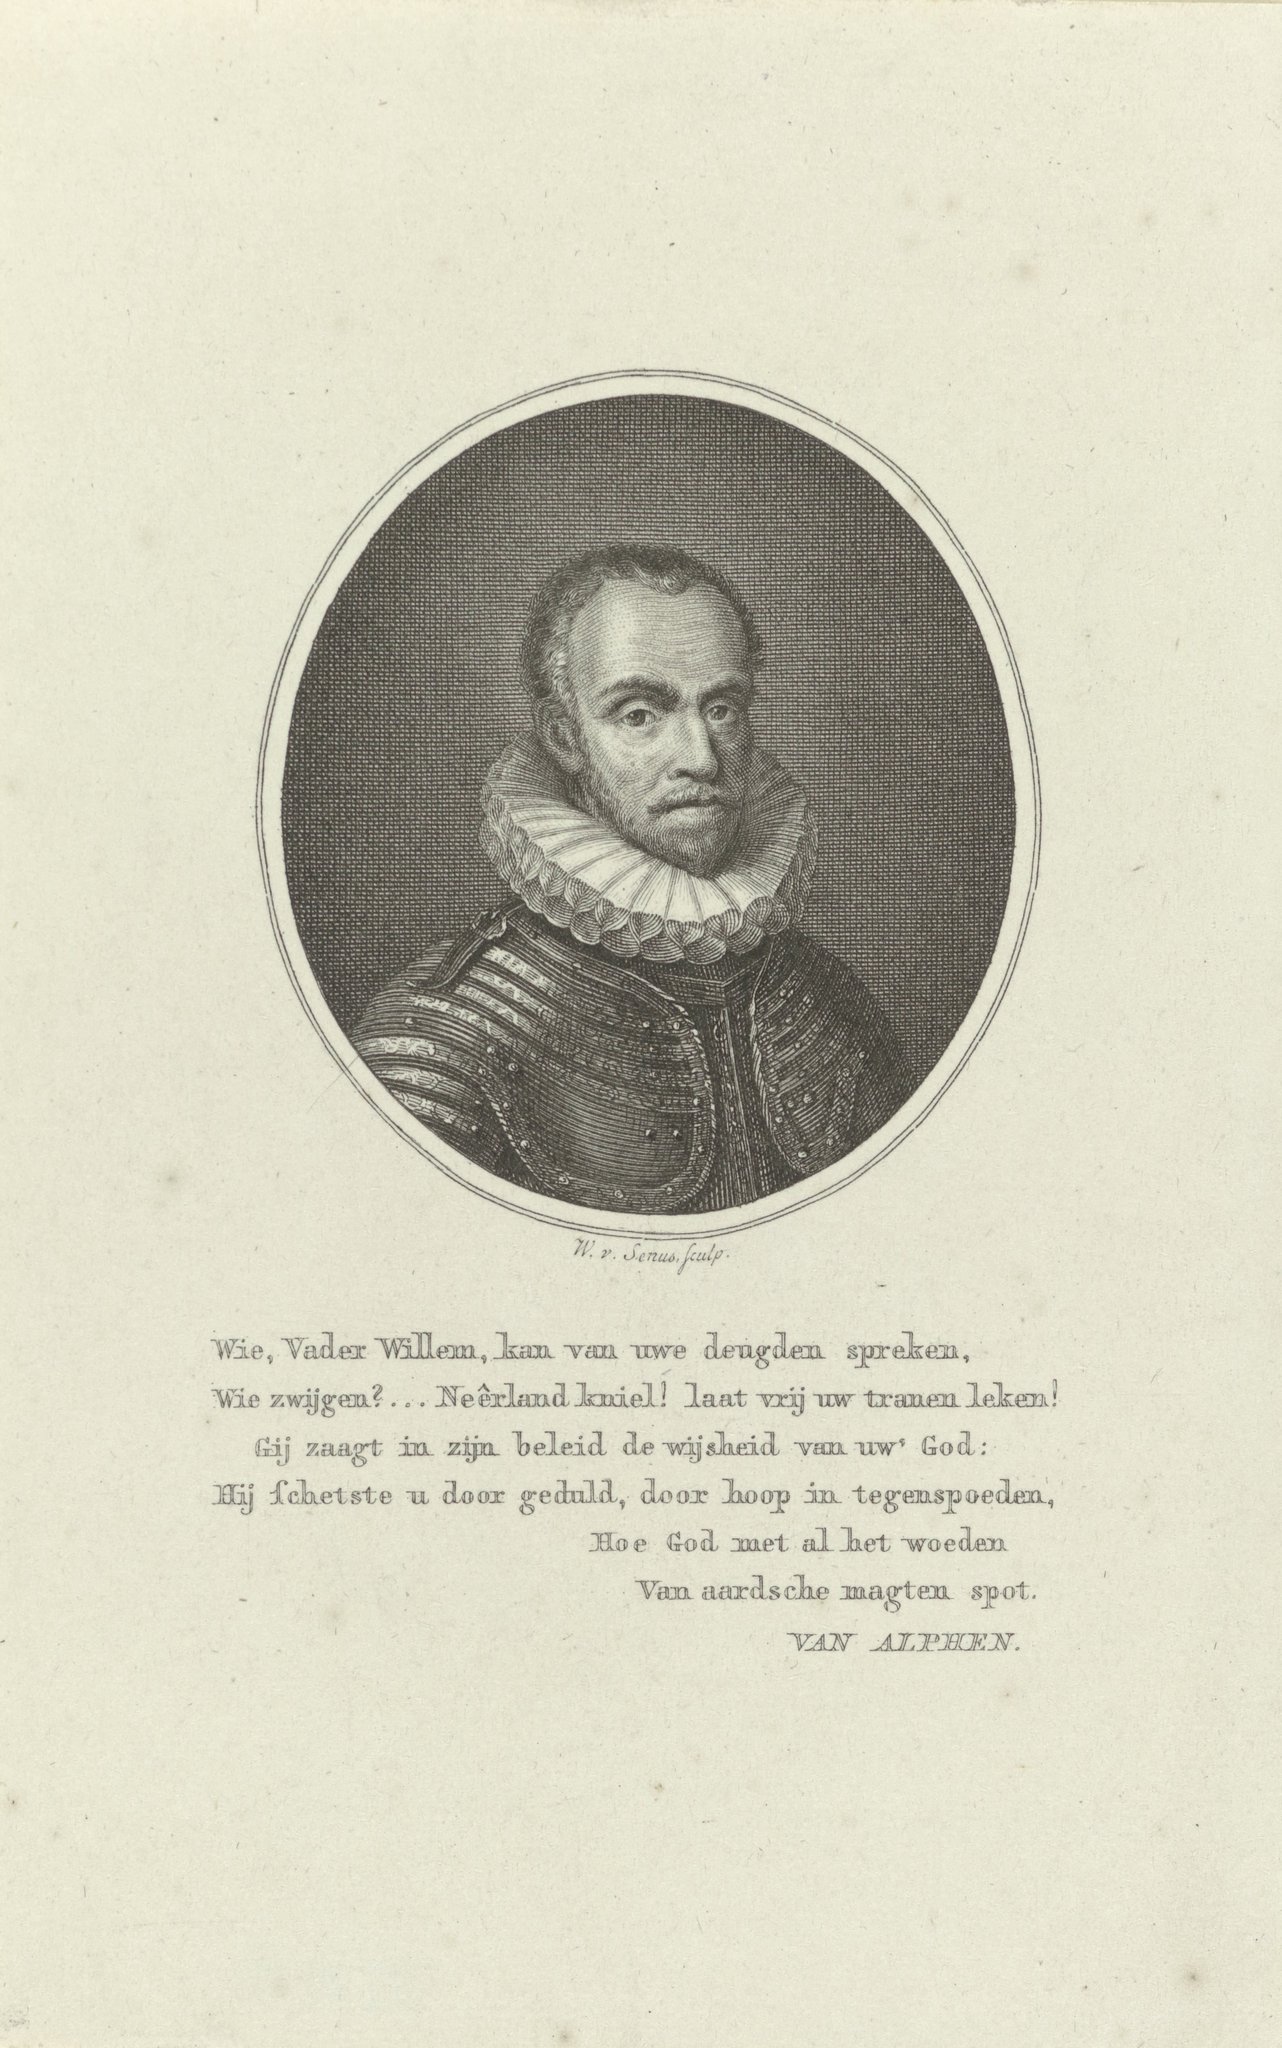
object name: print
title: Portret van Willem I, prins van Oranje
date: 1787-1851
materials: paper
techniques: engraving, etching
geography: northern netherlands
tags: delft, william i (prince of orange)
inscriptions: collector's mark: Lugt 2228, collector's mark: Lugt 2233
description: De hier vermelde titel verwijst naar de hoogst verkregen titel van de geportretteerde, niet per se naar de titel die de geportretteerde op deze voorstelling draagt.